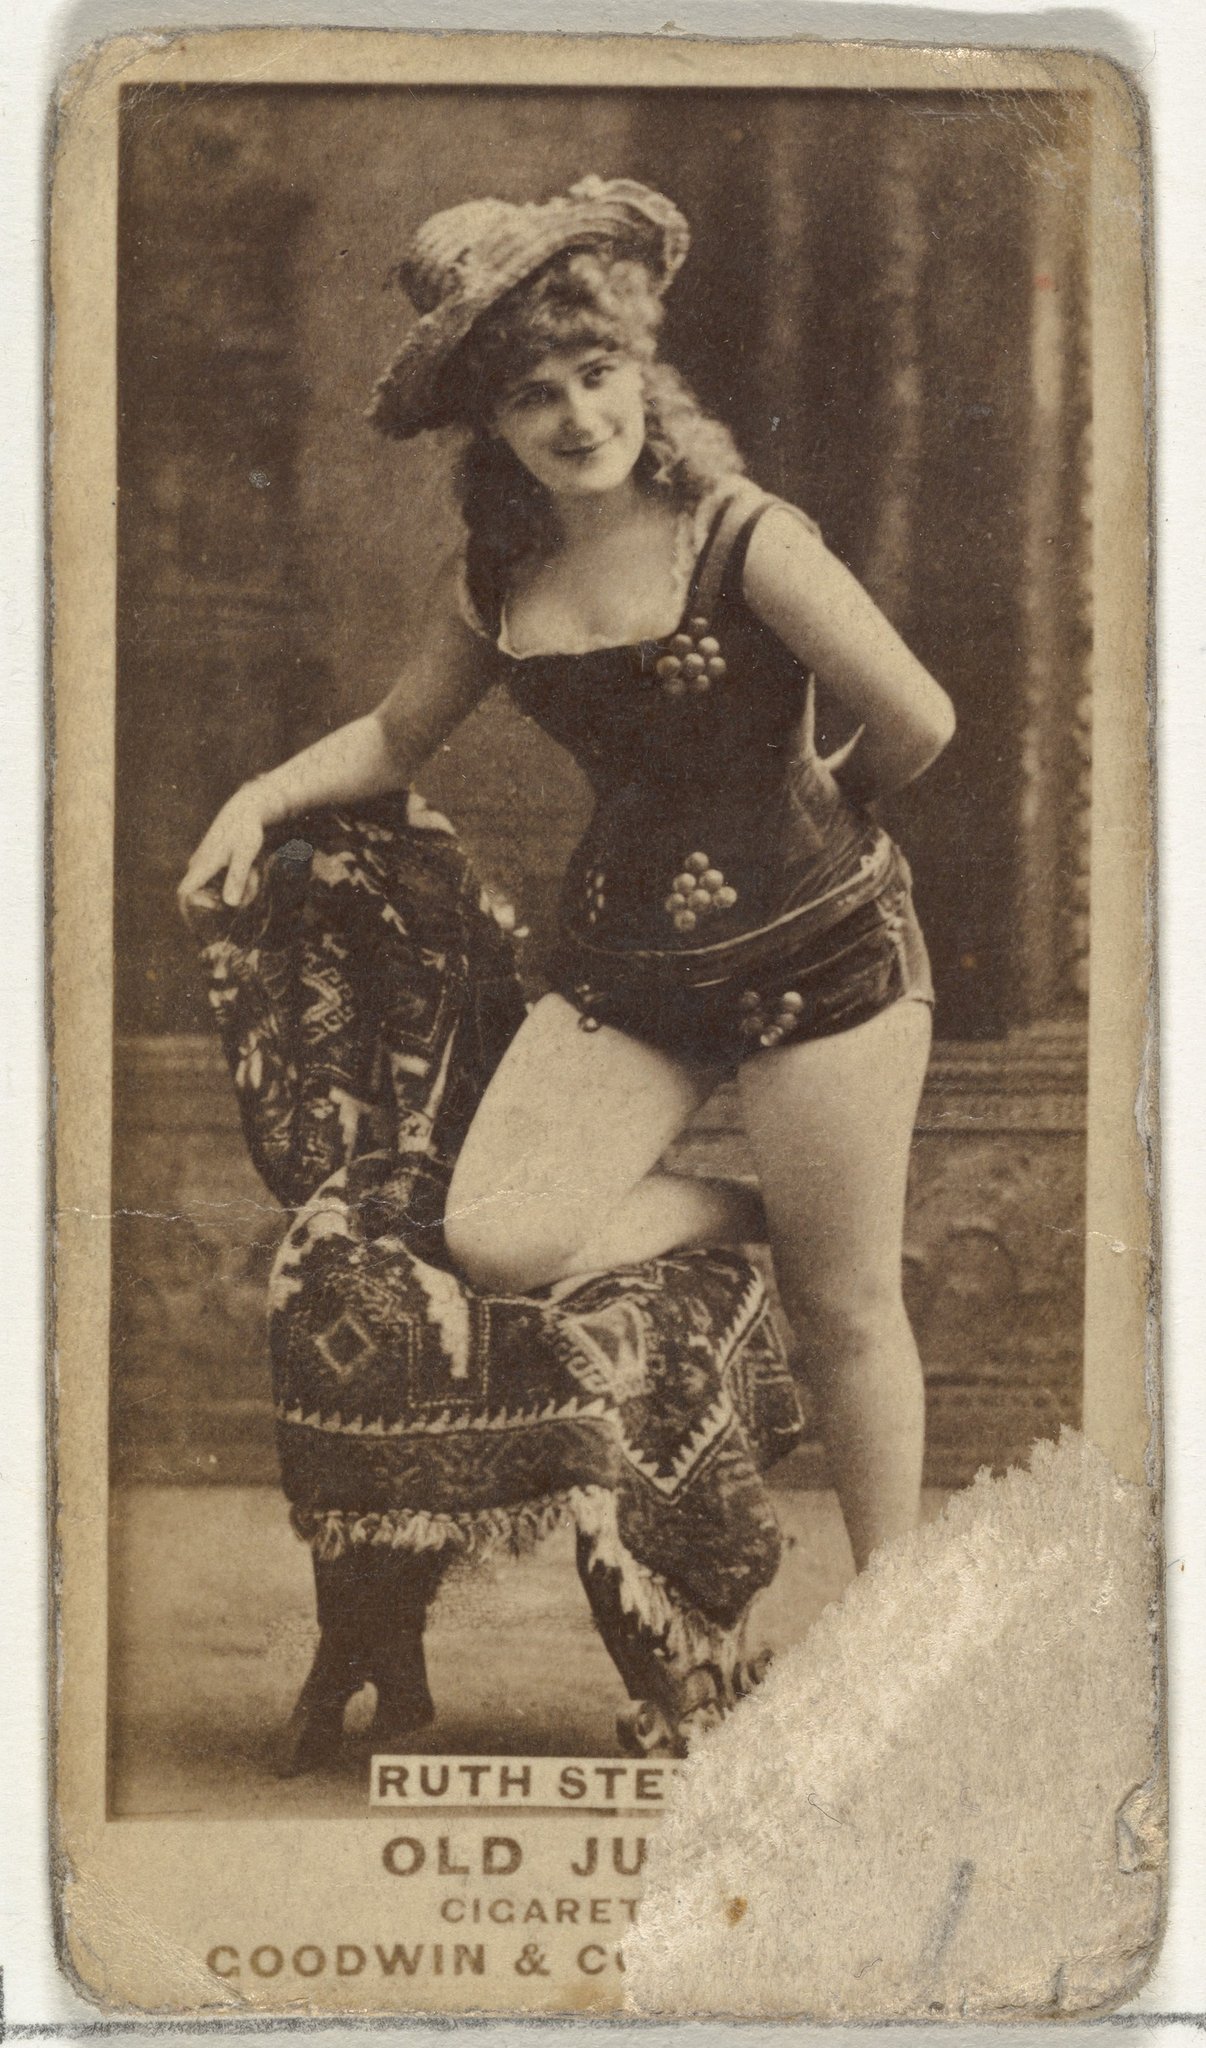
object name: photograph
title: From the Actors and Actresses series (N171) for Old Judge Cigarettes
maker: goodwin & company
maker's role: publisher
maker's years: 1850-1950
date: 1886-1890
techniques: albumen silver print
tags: portraits,women,actresses